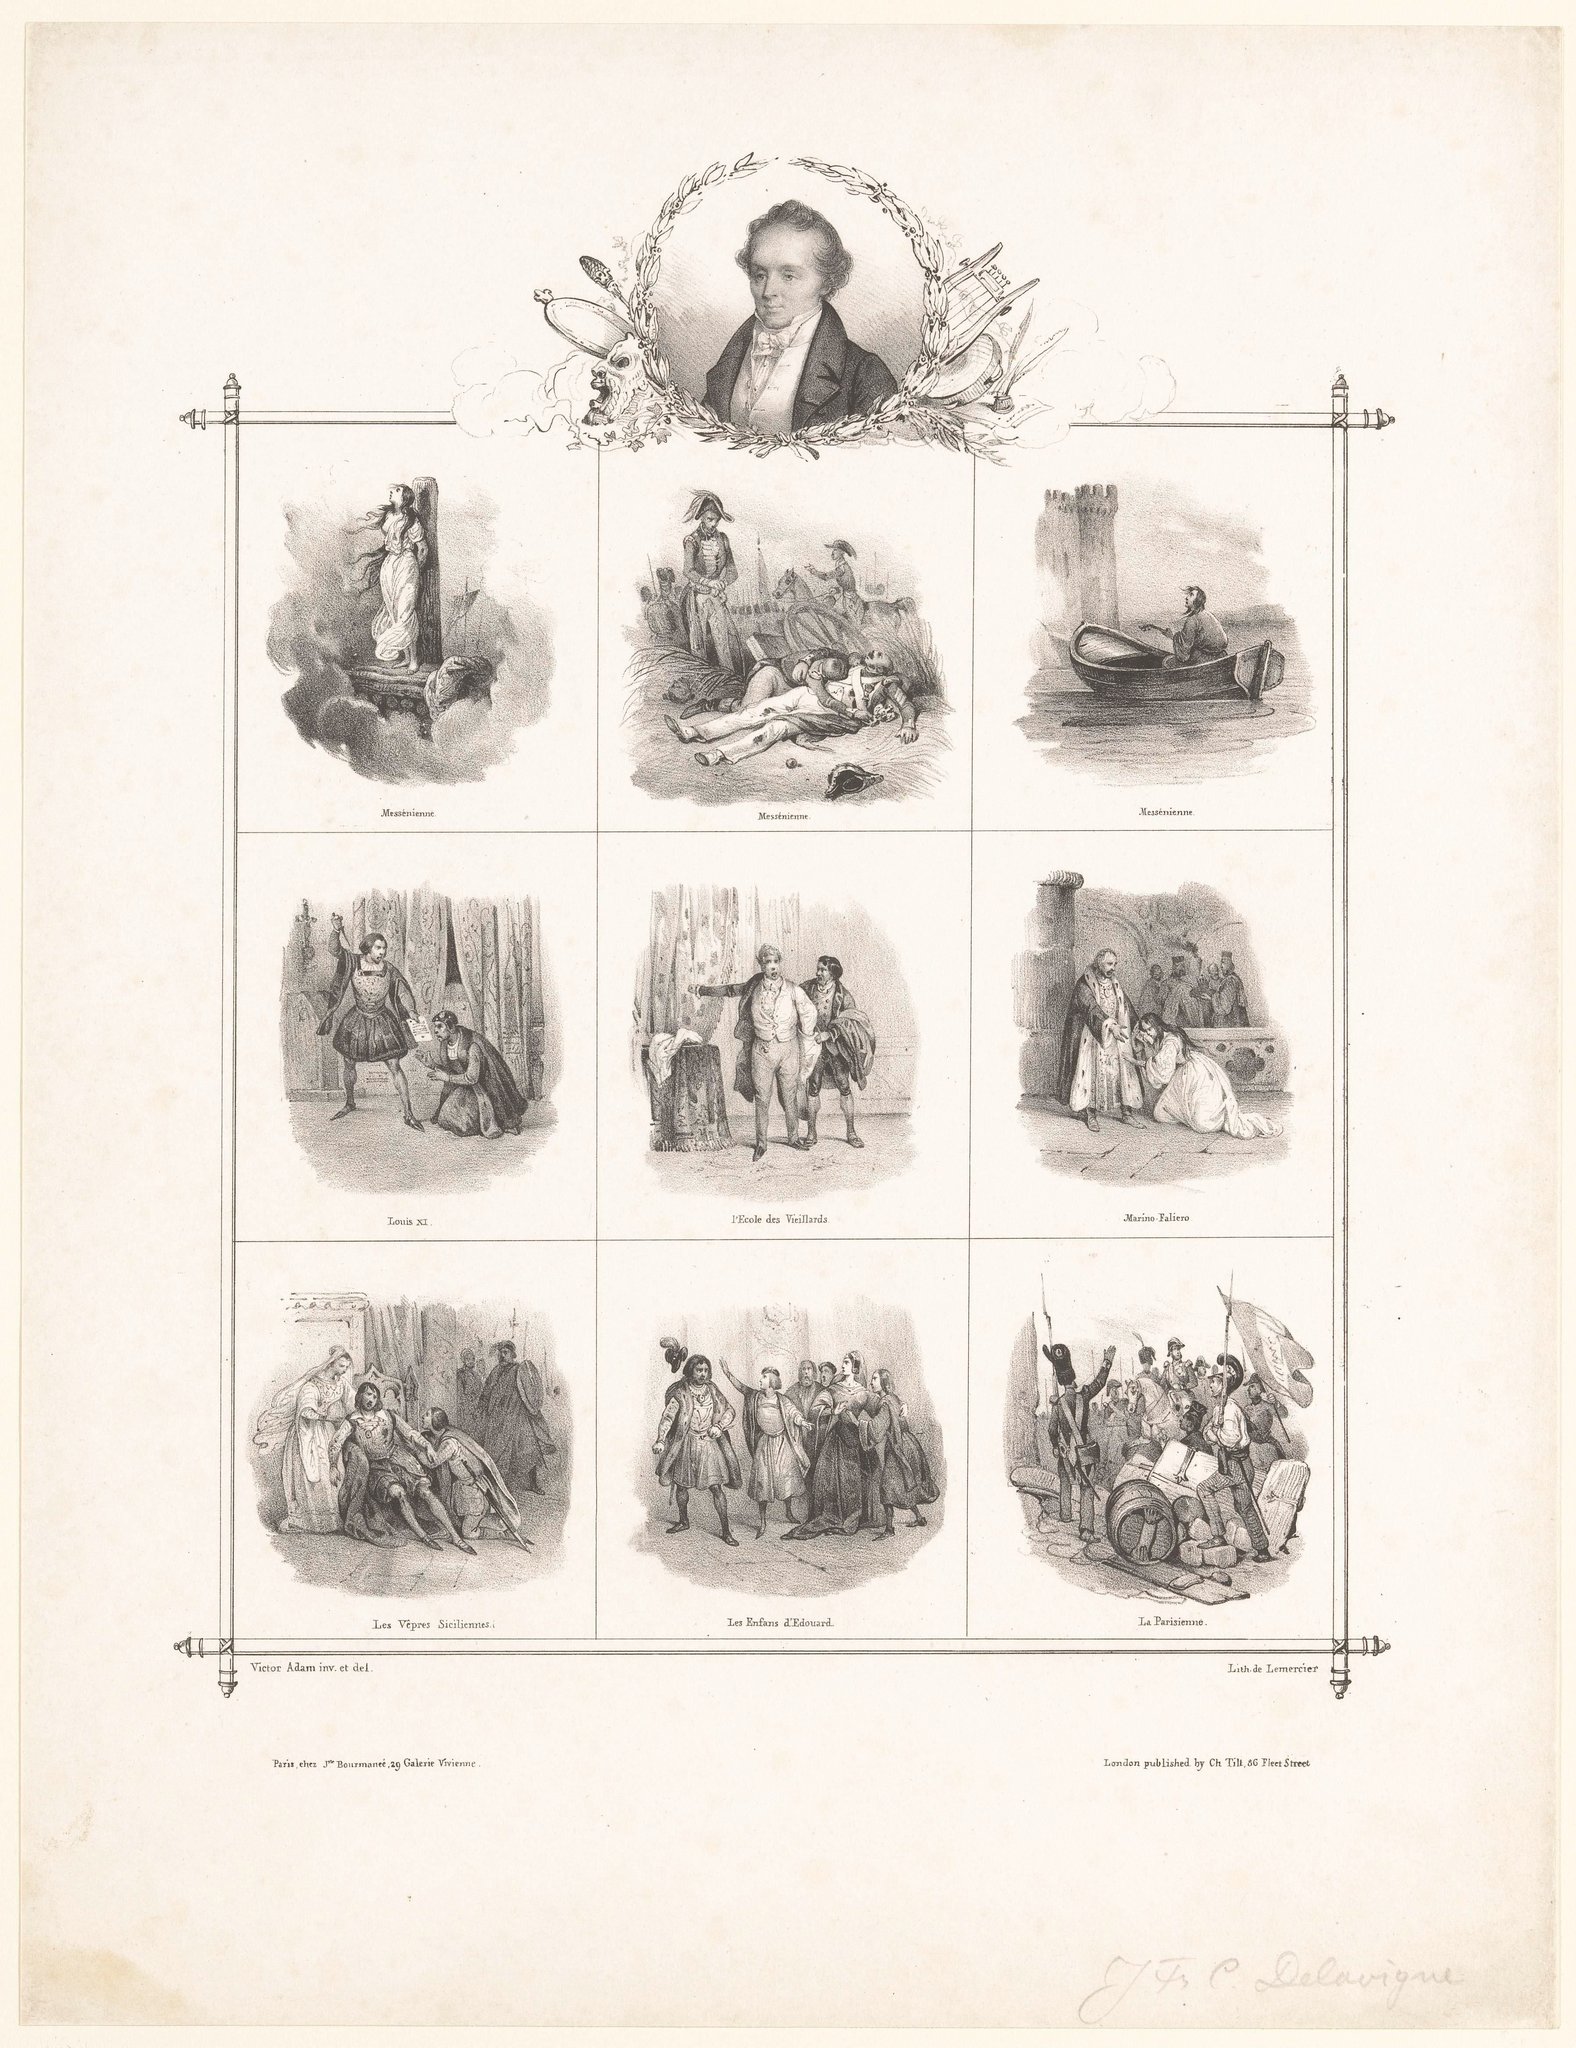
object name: print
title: Portretten van schrijvers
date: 1834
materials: paper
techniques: lithograph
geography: paris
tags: historical persons, portrait of a writer, (scenes from) specific works of literature (with author, title)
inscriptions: collector's mark: Lugt 2228, annotation: ‘J. Fr. C. Delavigne’